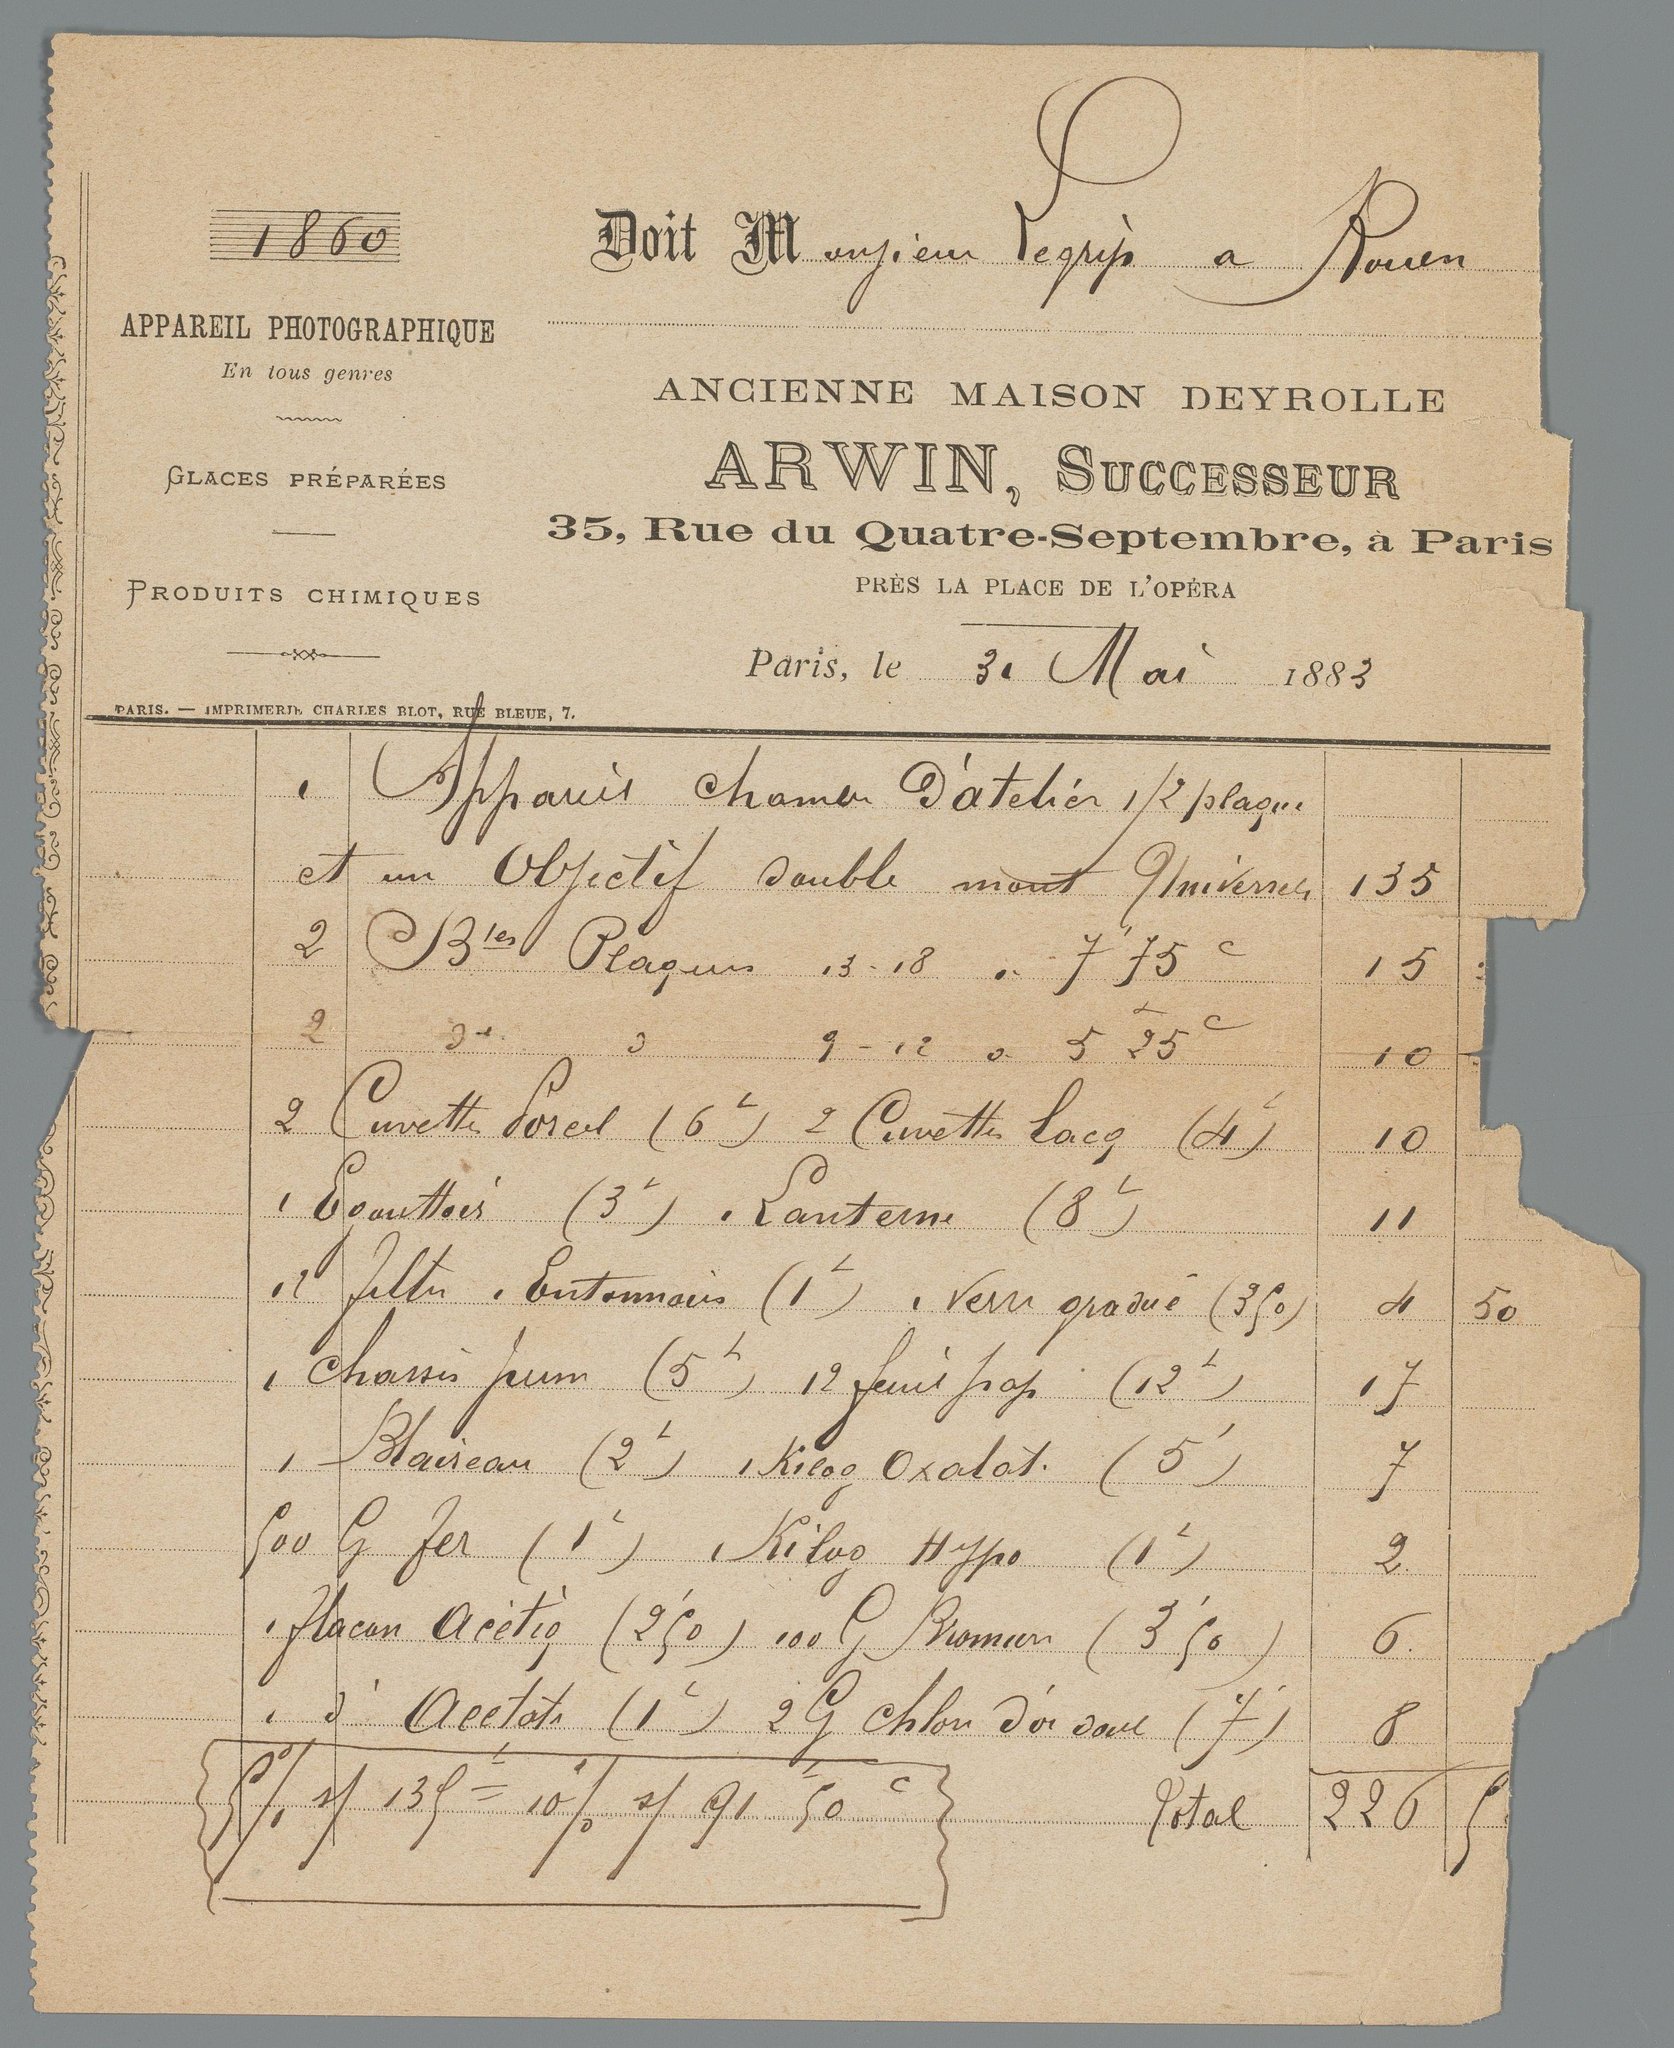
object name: account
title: Rekening van Maison Deyrolle gericht aan de heer Legrip uit Rouen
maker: charles blot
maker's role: printer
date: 1883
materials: ink, paper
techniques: pen, printing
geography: paris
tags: cheque, draft, bill of exchange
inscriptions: number: ‘1860’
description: Brief horend bij de publicatie 'Fabrique d'appareils photographiques de tous models ... [etc] : catalogue et notice 1883, annulant les précédents', exemplaarnummer h4457.